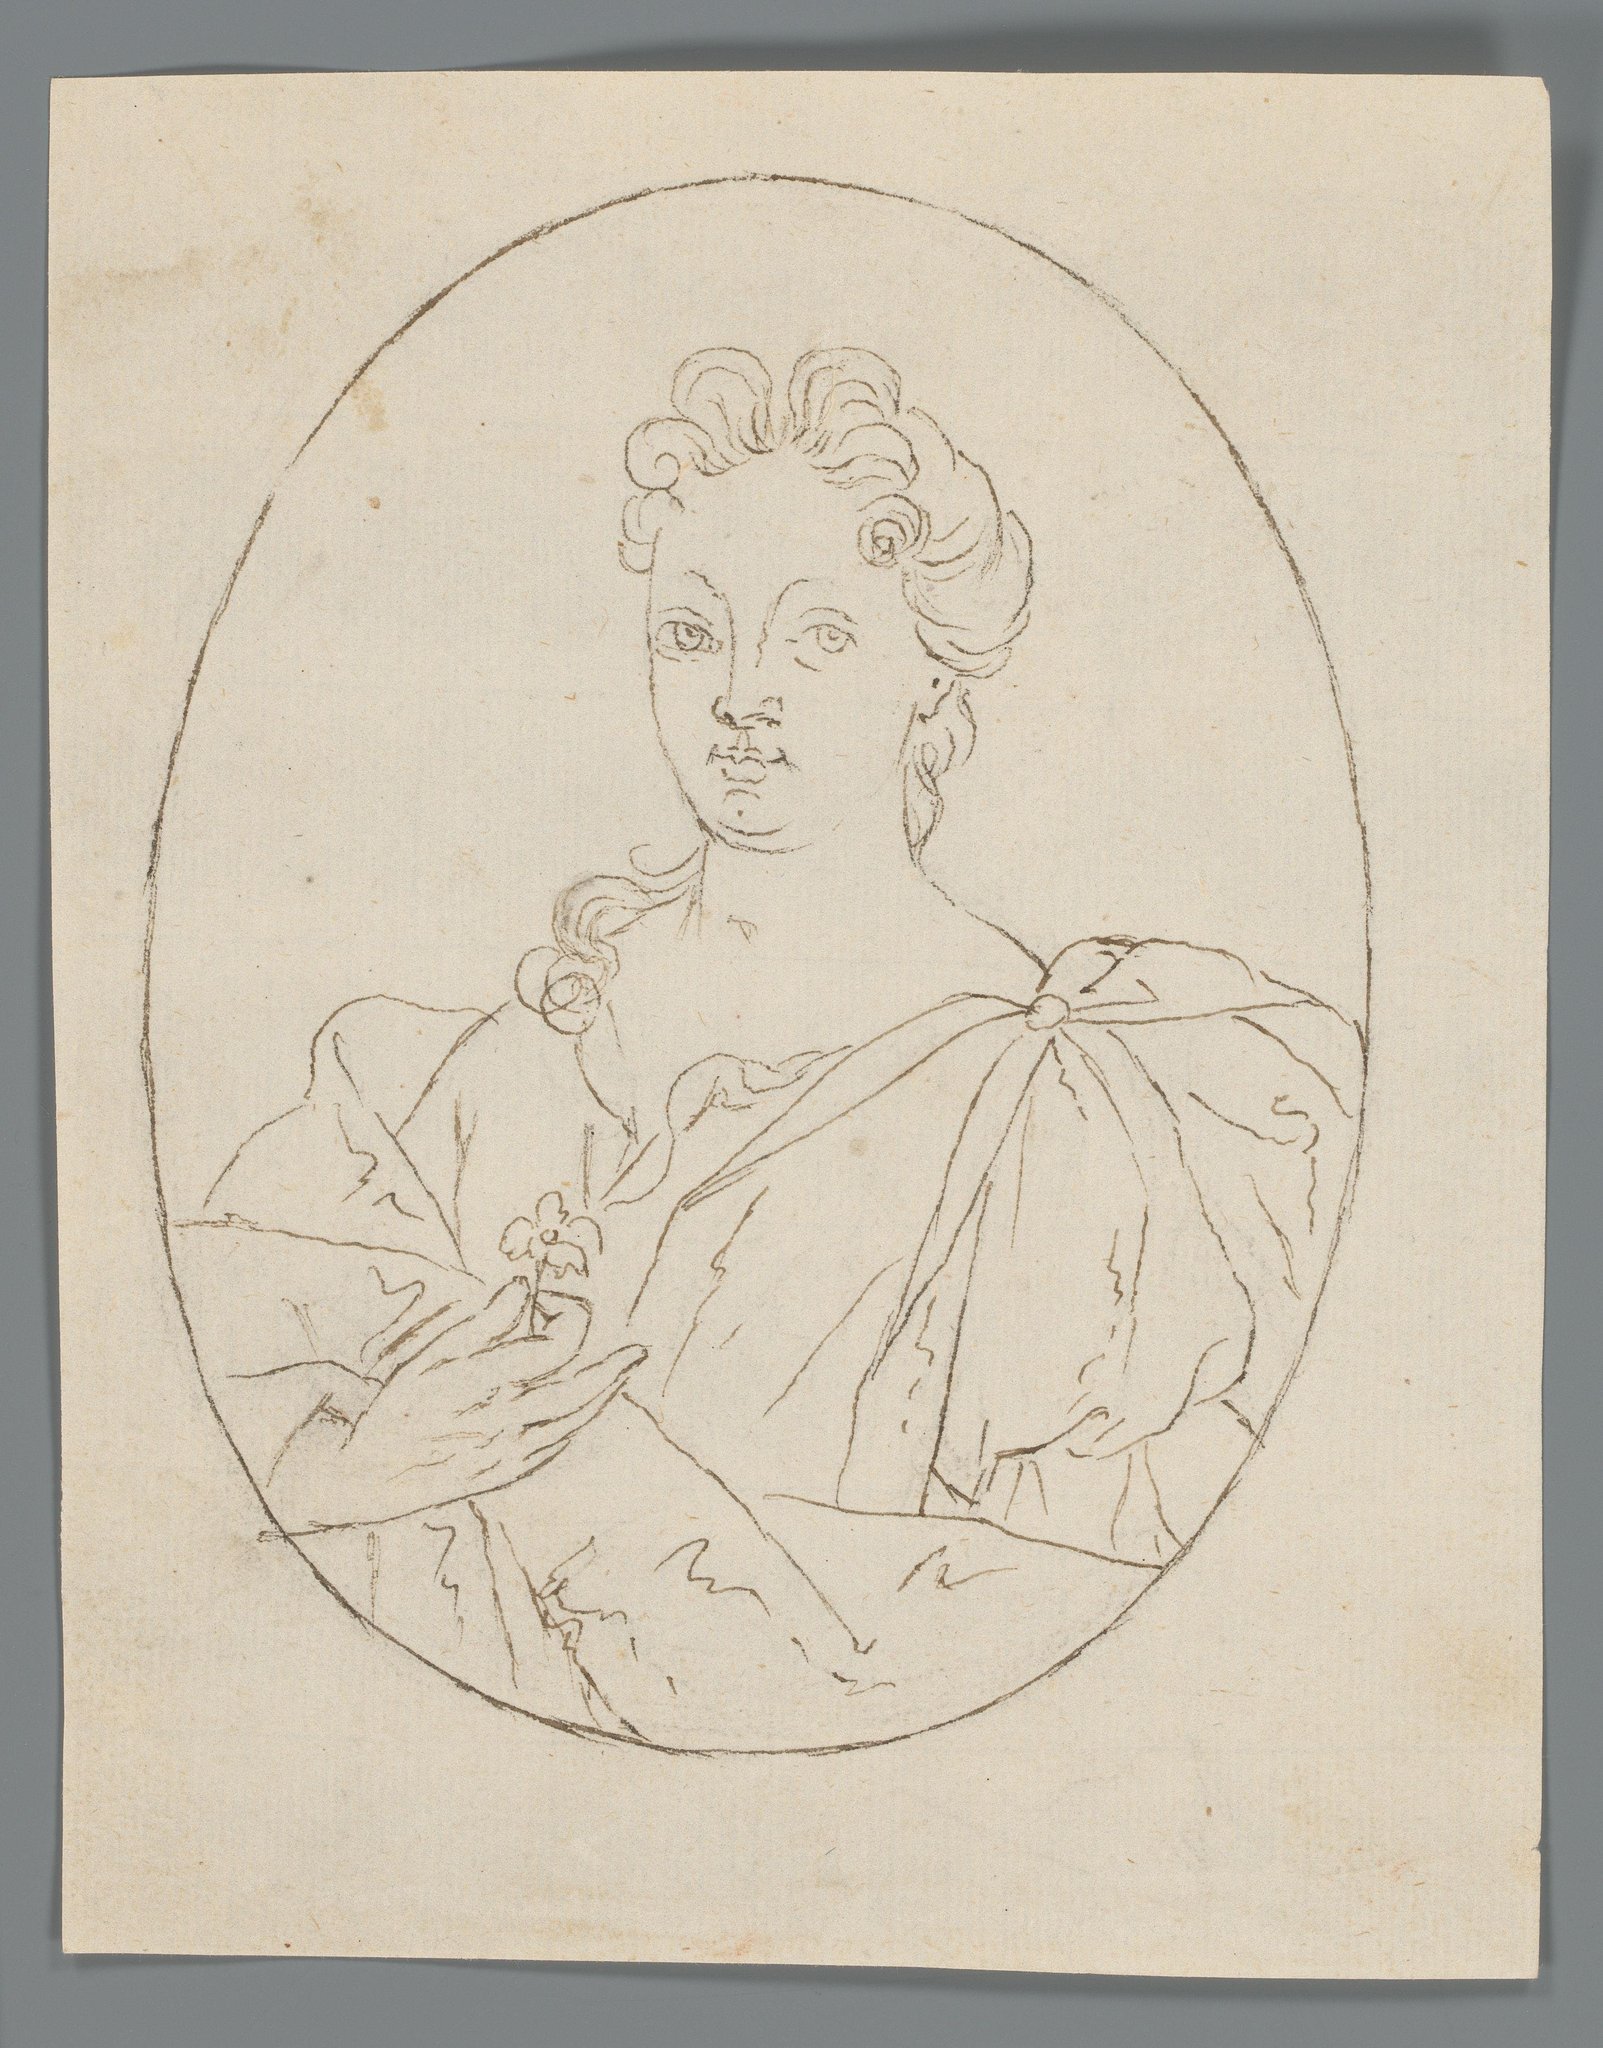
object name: drawing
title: Portret van een vrouw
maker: matthijs balen (1684-1766)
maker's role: draughtsman, painter, print maker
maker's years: 1684-1766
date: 1694-1766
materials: paper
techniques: pen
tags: historical persons not known by name - bb - woman